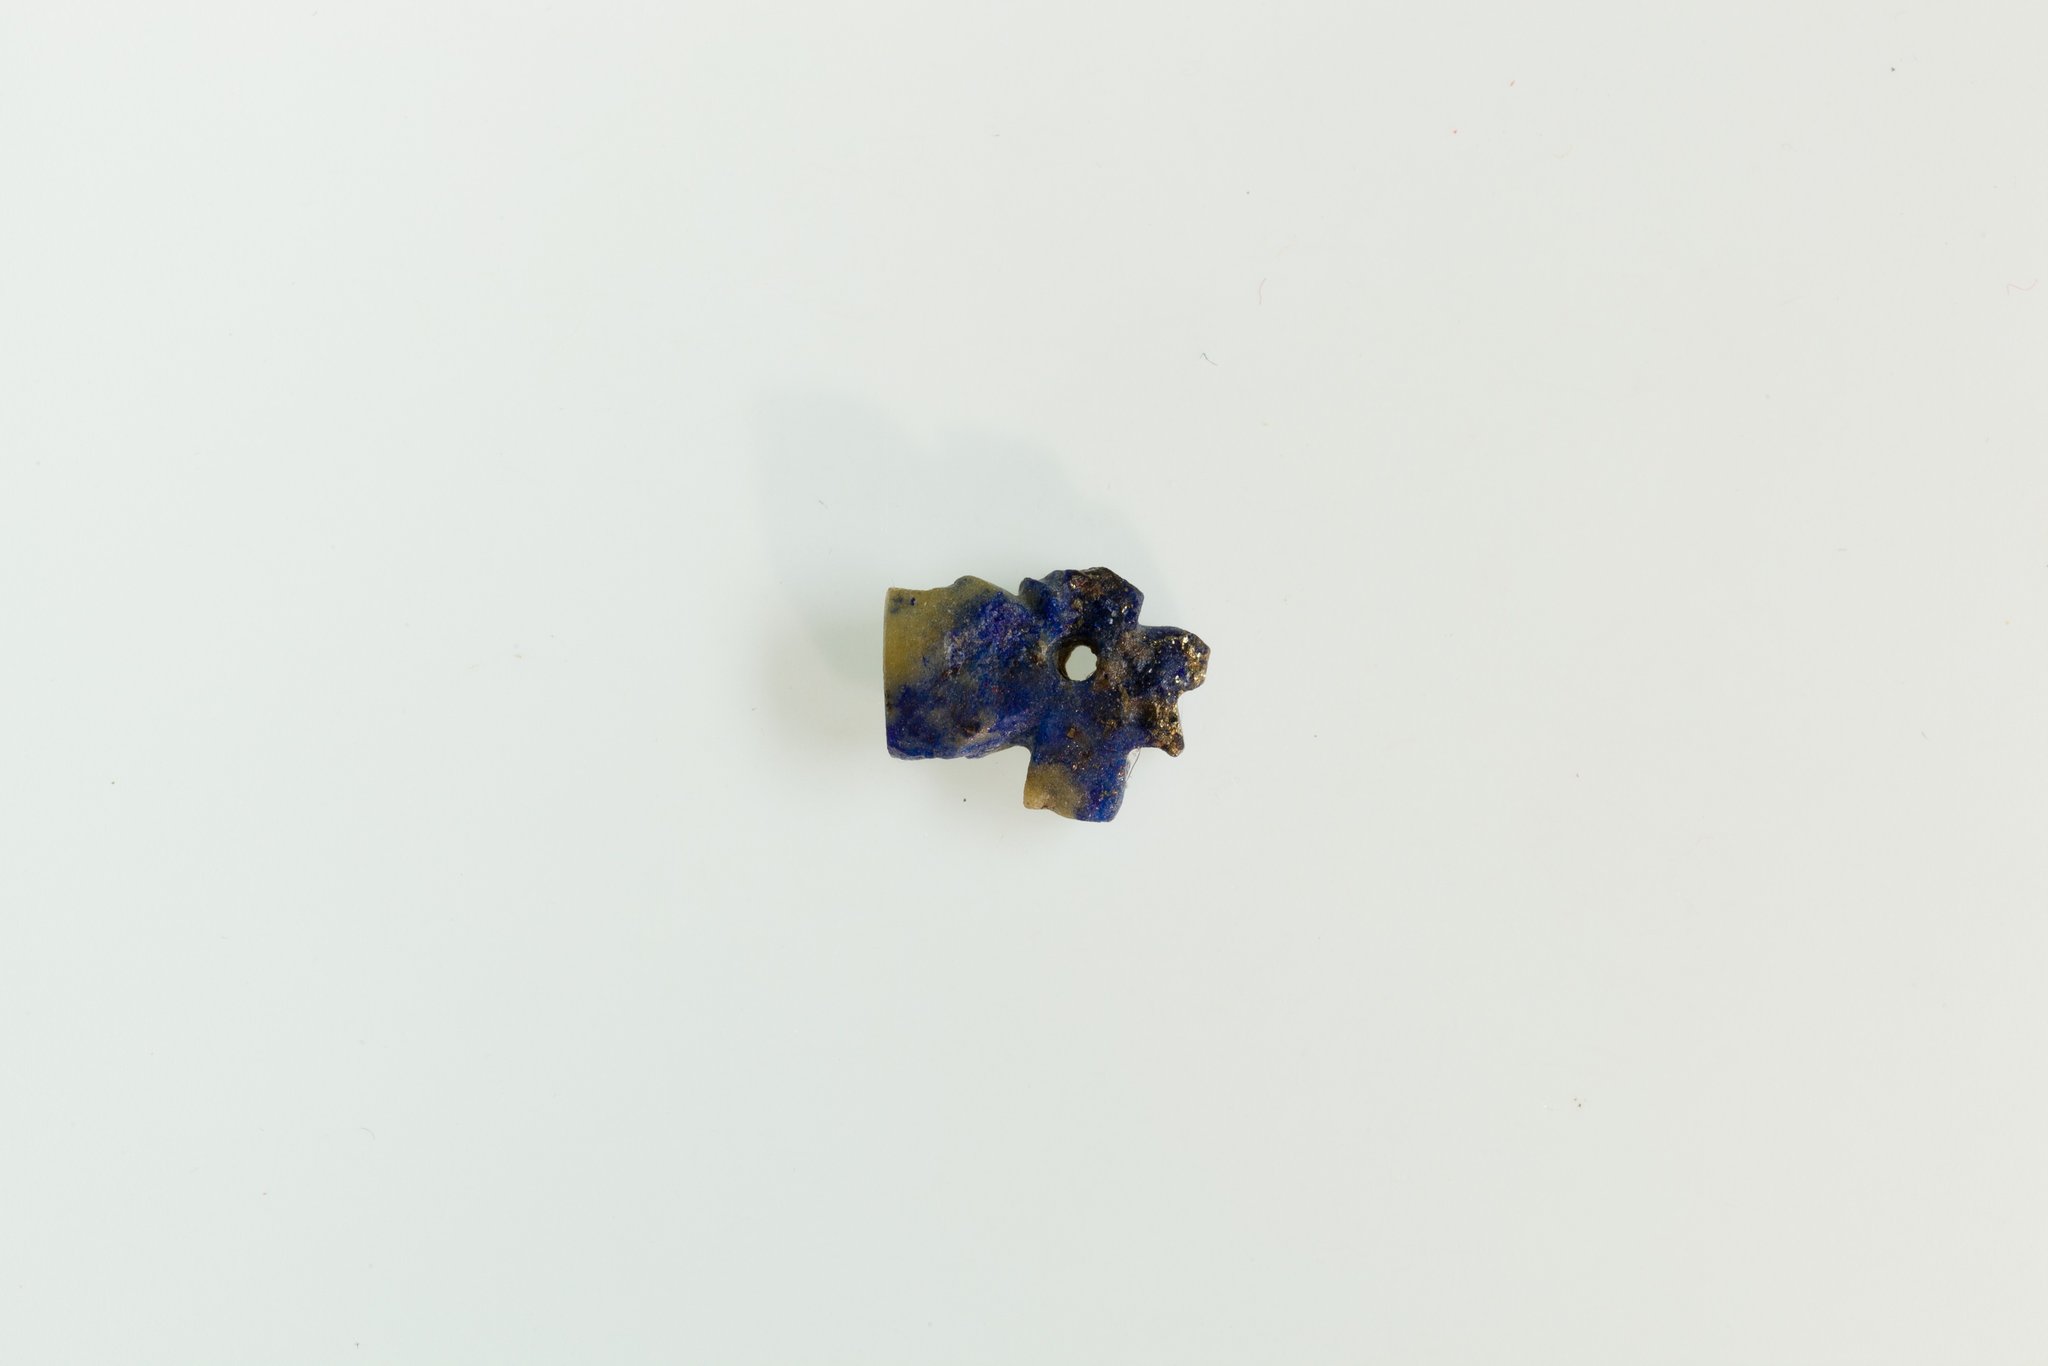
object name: amulet, wedjat eye, tiye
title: Wedjat Amulet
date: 1070-945 BCE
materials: lapis lazuli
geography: egypt